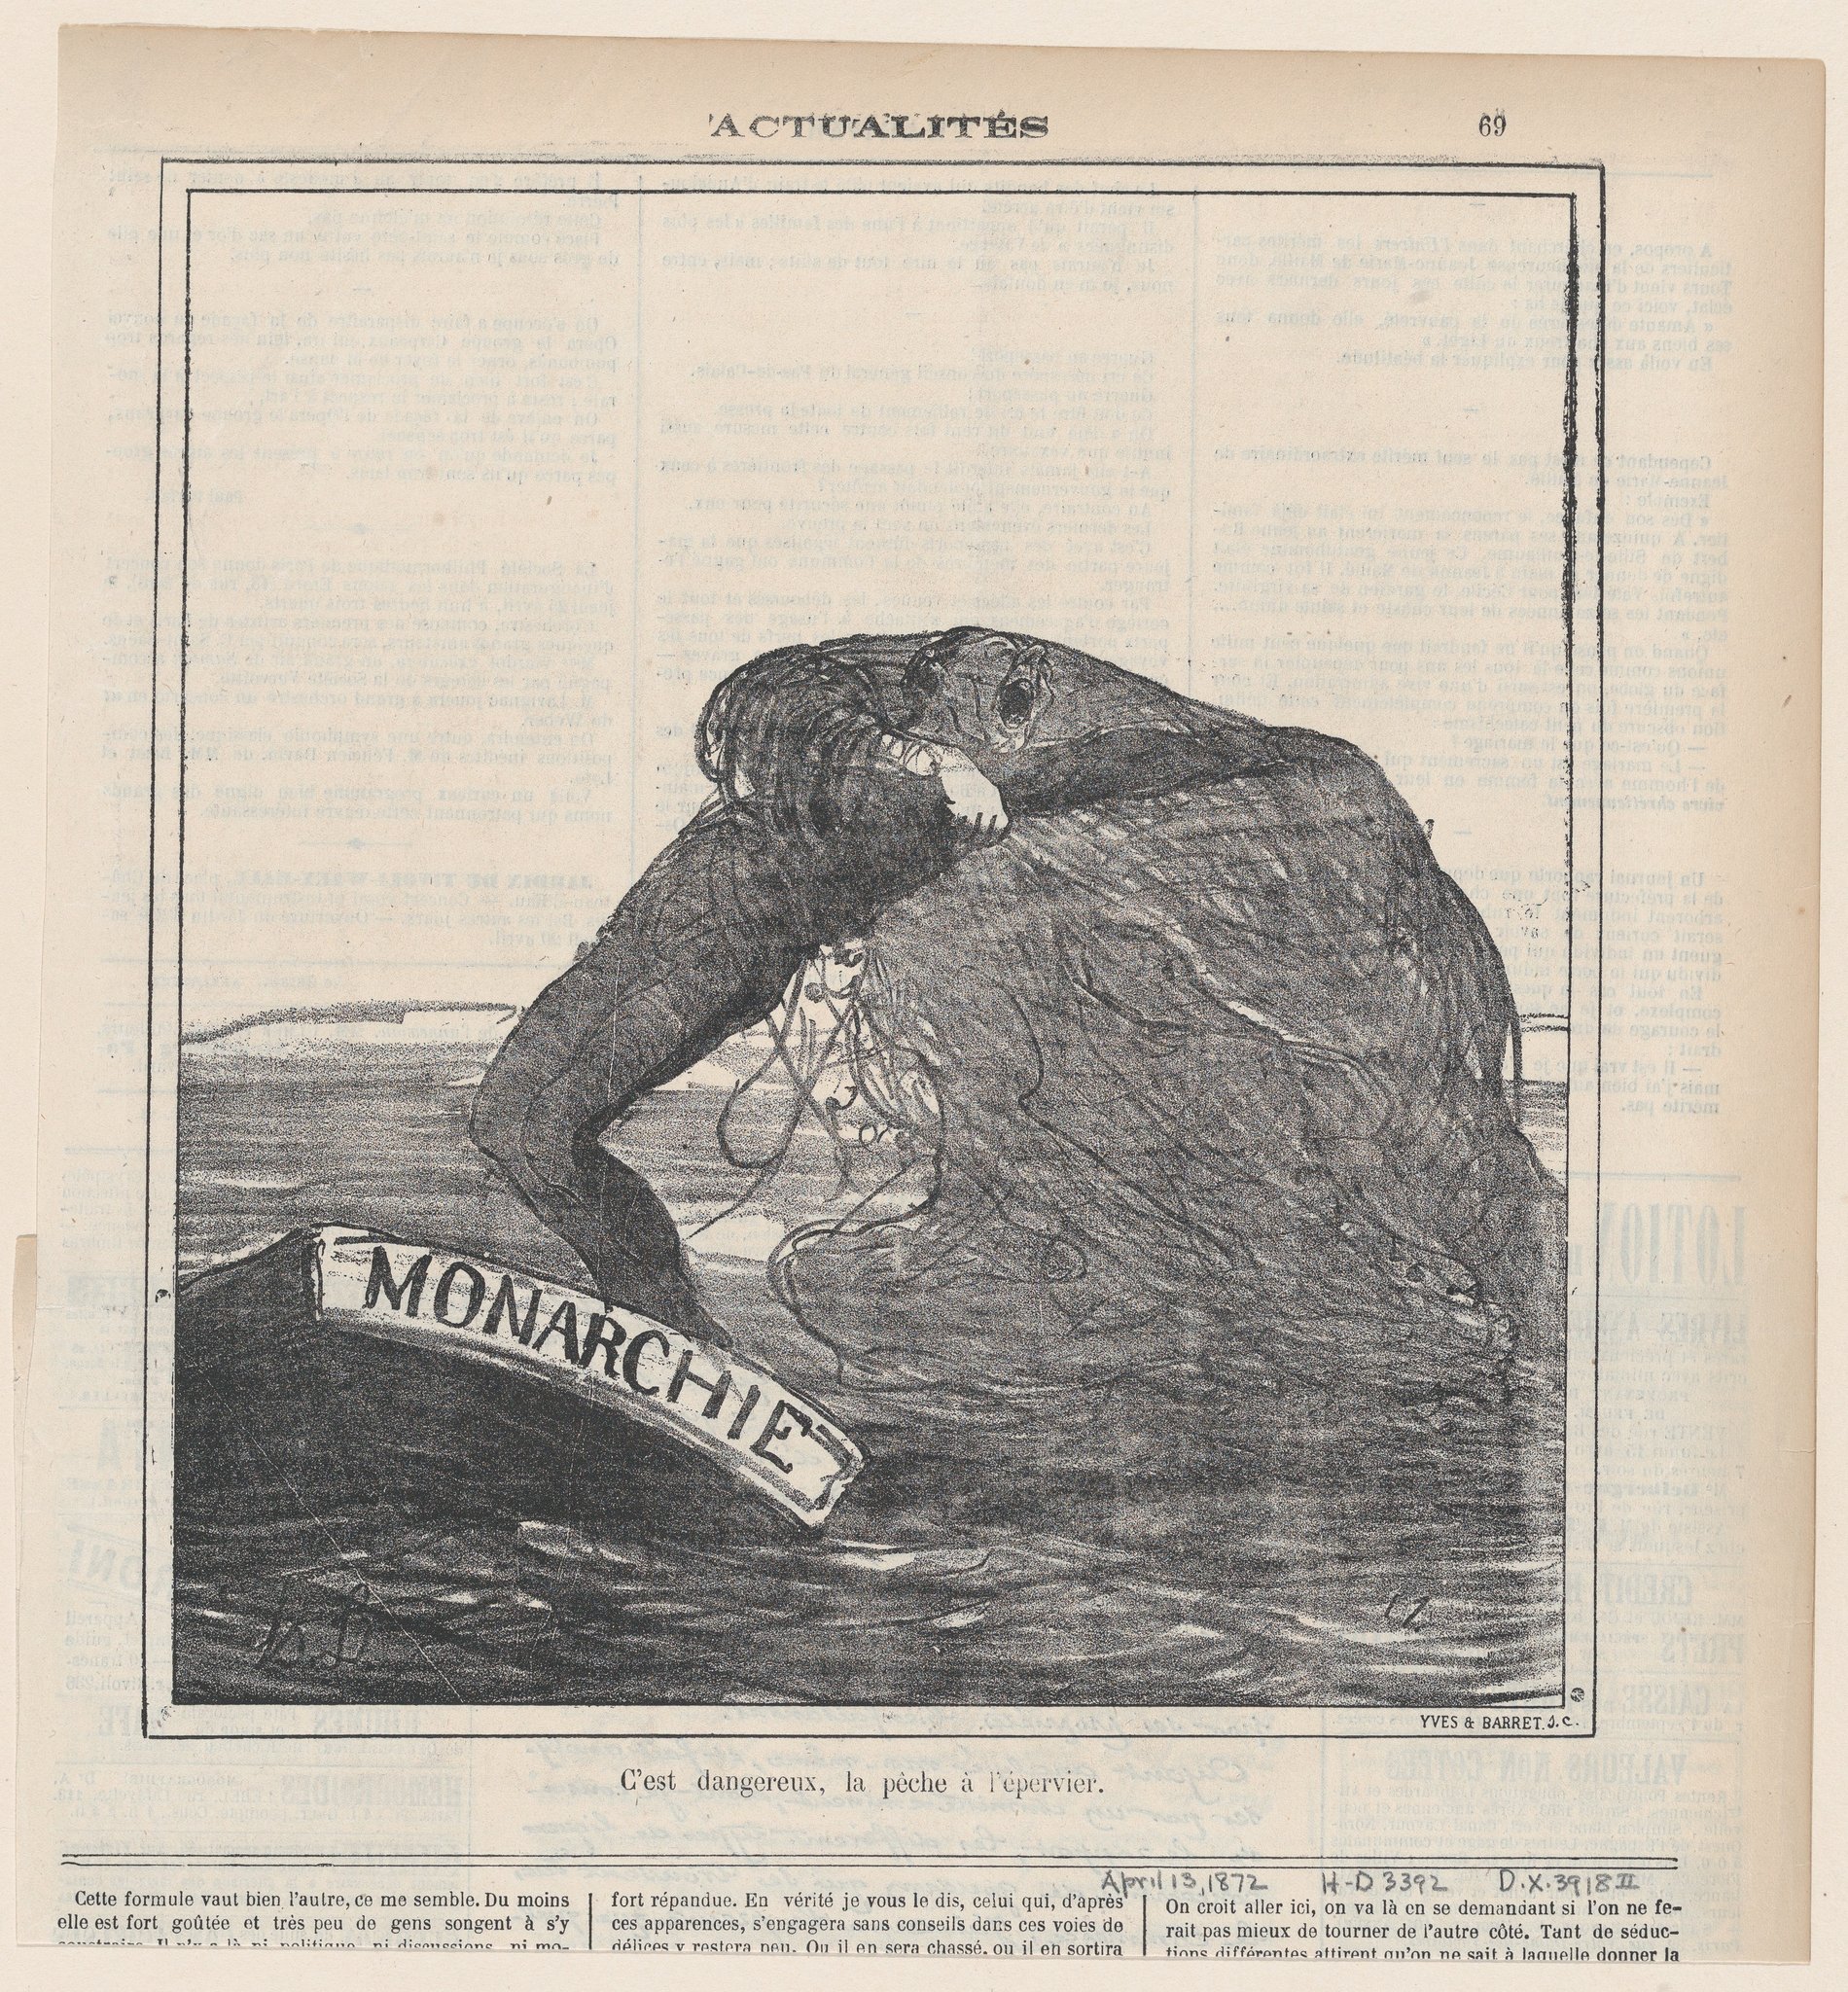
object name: print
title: Fishing with a sweep-net can be dangerous, from 'News of the day,' published in Le Charivari, April 13, 1872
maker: honoré daumier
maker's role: artist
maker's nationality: french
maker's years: 1808-1879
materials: paper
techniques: lithograph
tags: fishing